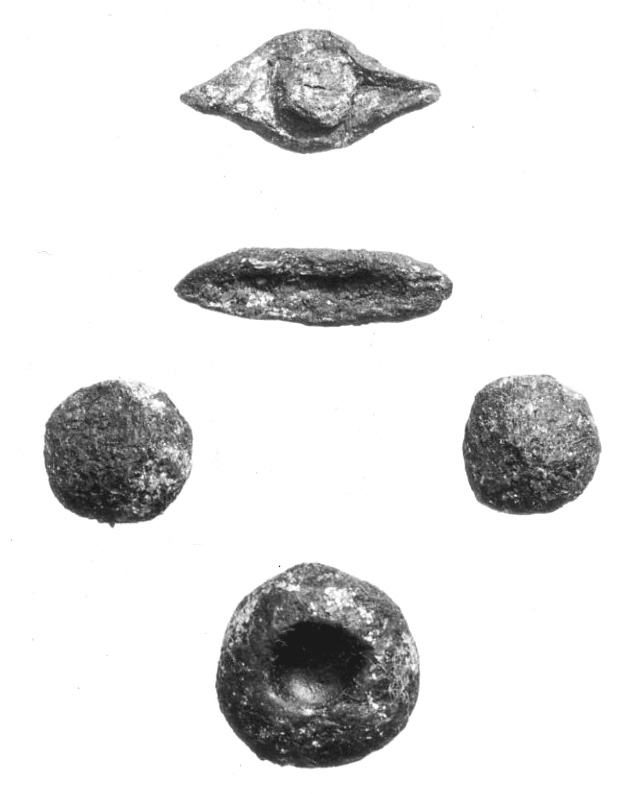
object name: amulet, set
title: Set of amulets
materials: gold leaf, wax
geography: egypt